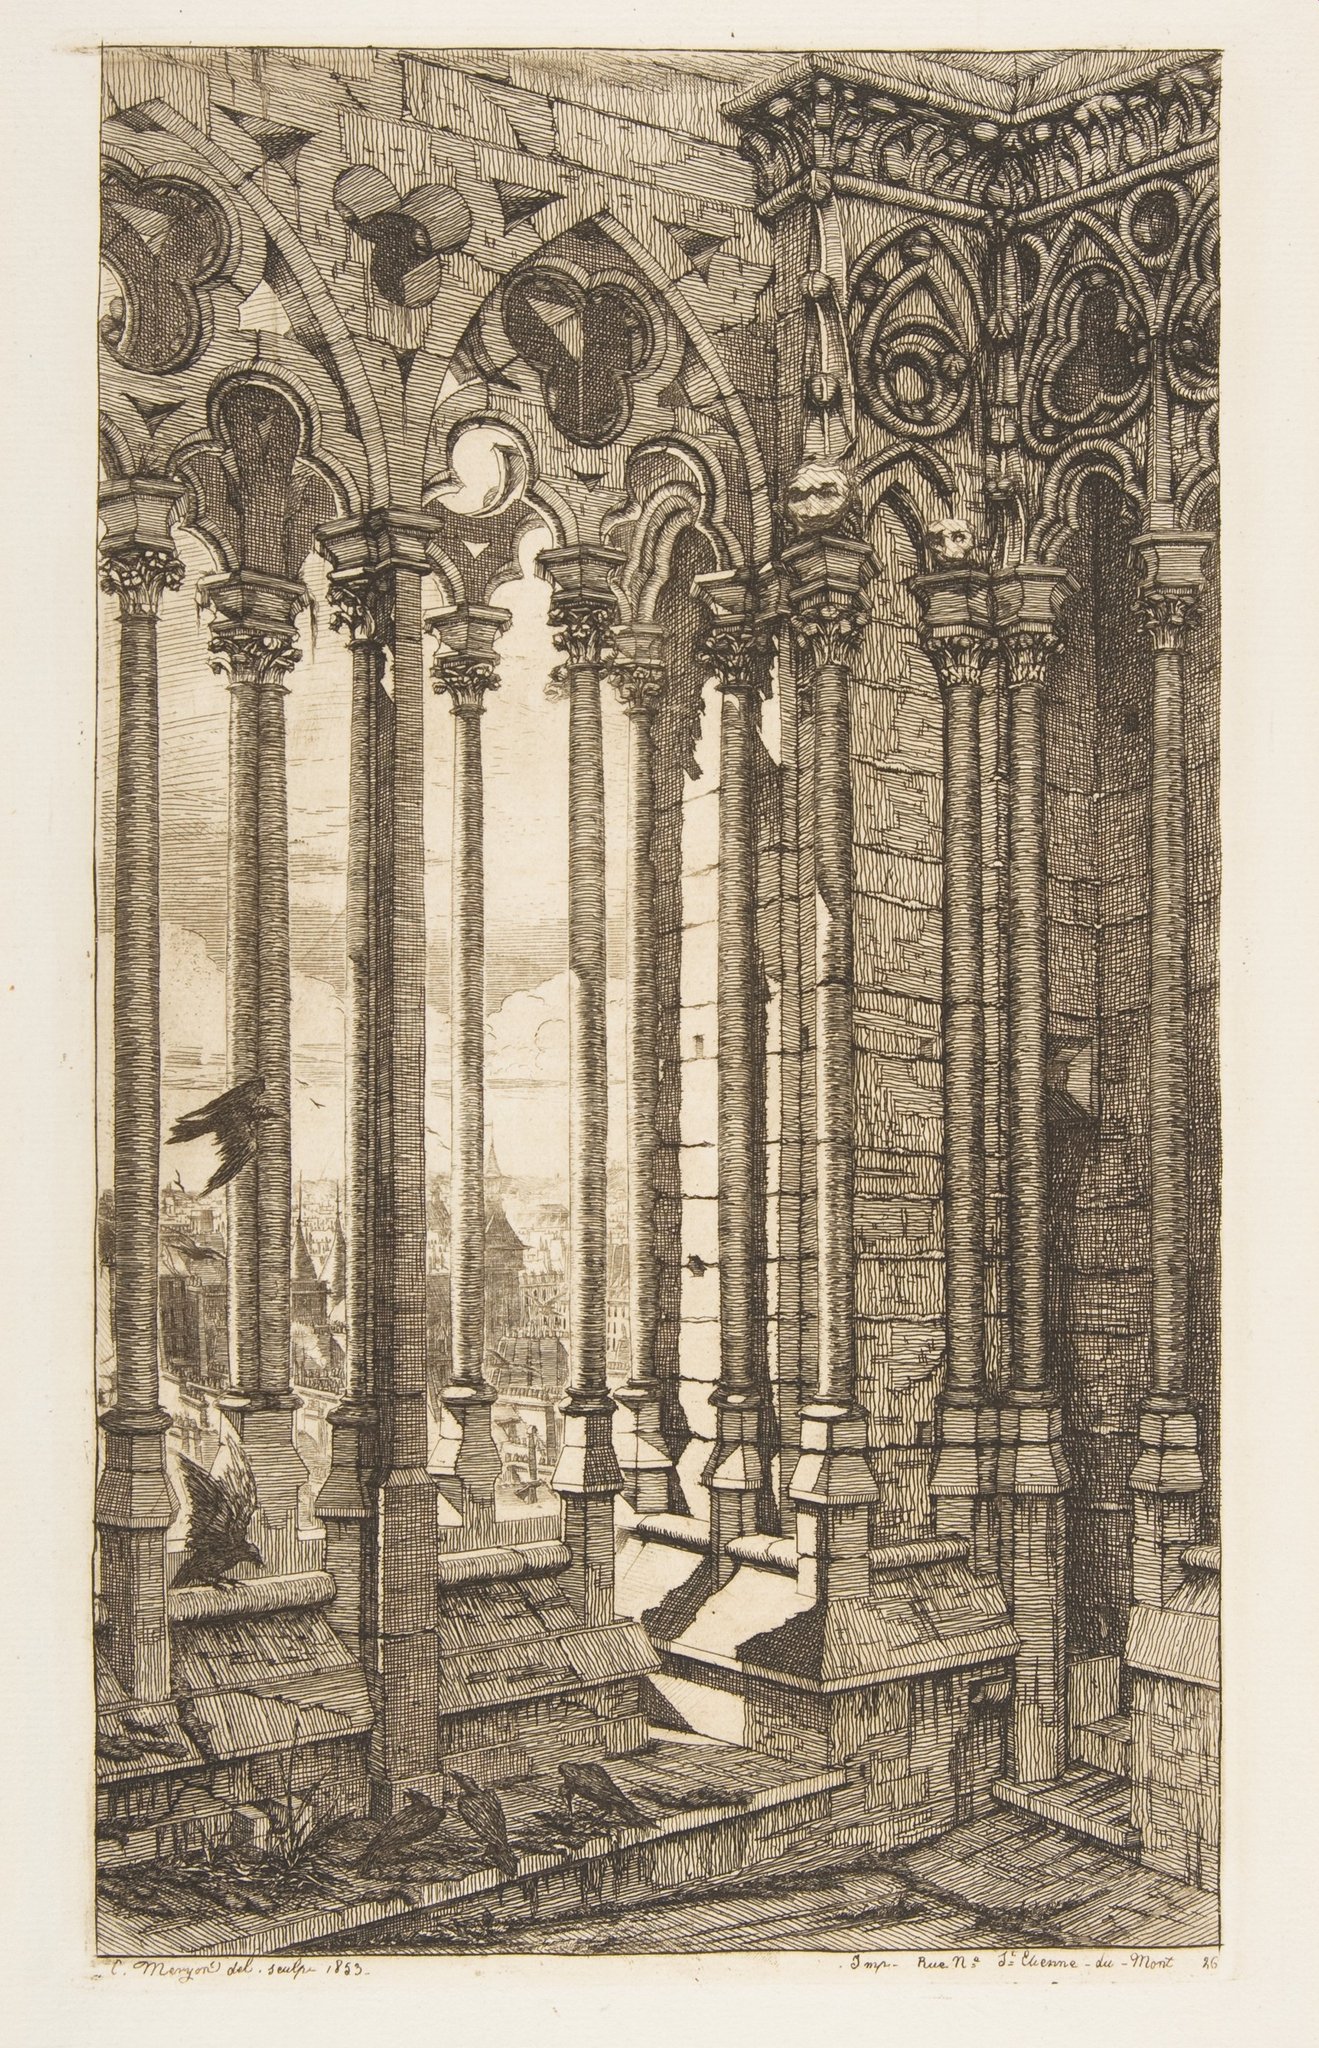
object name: print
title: Gallery, Nôtre-Dame Cathedral, Paris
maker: charles meryon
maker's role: artist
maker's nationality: french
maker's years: 1821-1868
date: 1853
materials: paper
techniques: etching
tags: columns,cathedrals,paris